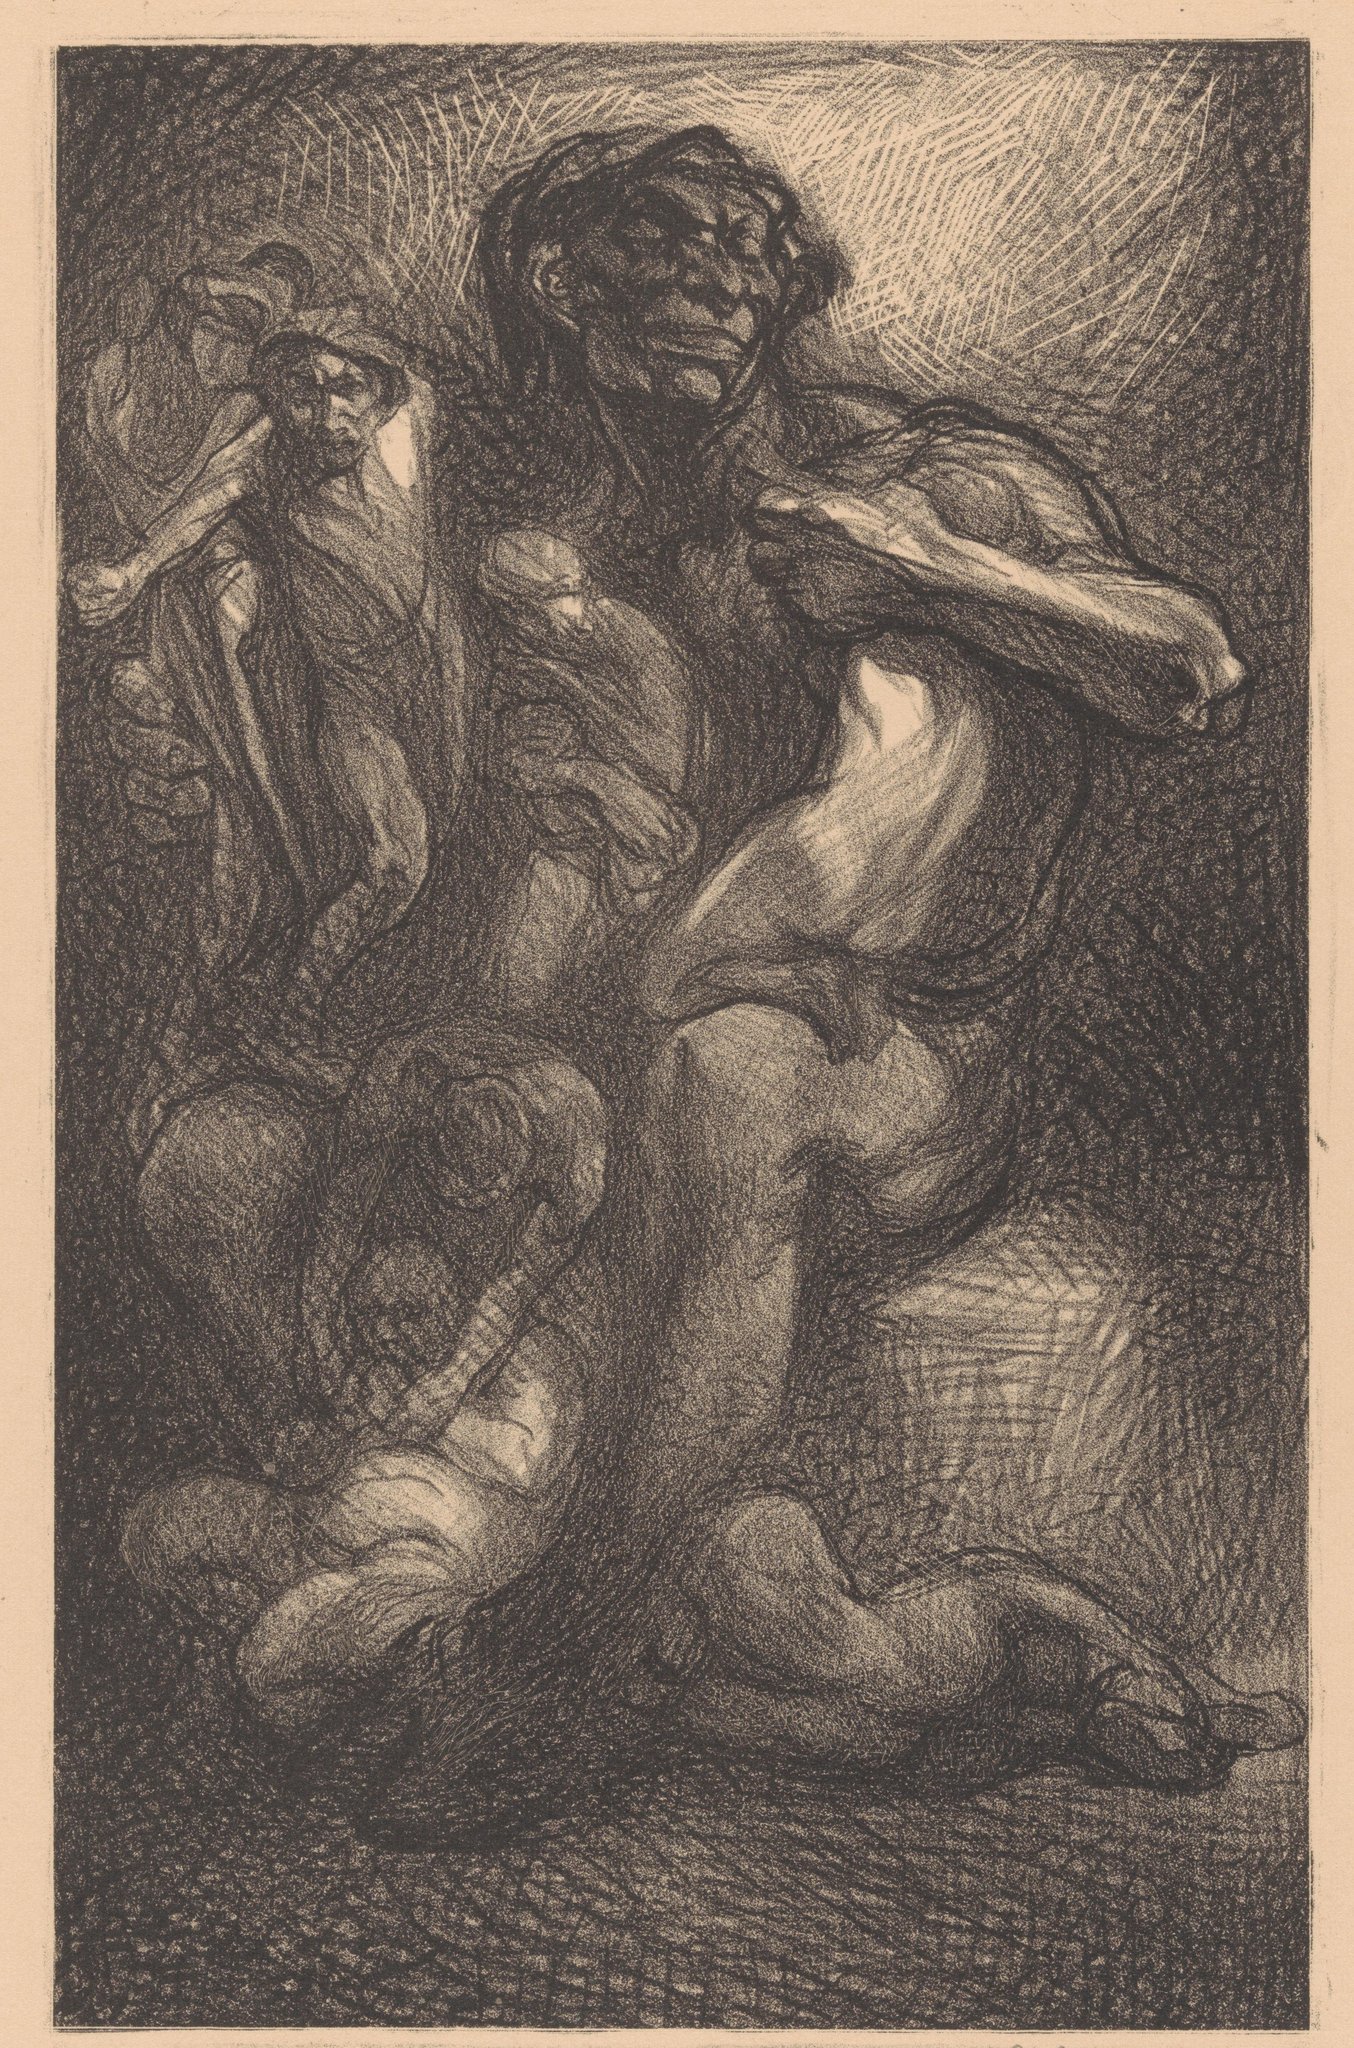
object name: print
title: Reus met mensen op schoot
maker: johannes josephus aarts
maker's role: draughtsman, print maker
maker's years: 1871-1934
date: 1927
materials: paper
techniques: lithograph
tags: littleness, smallness, the seven deadly sins (personified), sitting in someone's lap, giants, colossi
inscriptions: collector's mark: Lugt 2228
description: Een reusachtige figuur met een verzameling staande, zittende en liggende mensen op schoot en aan zijn voeten, mogelijk voorstellend de duivel en de zeven hoofdzonden.